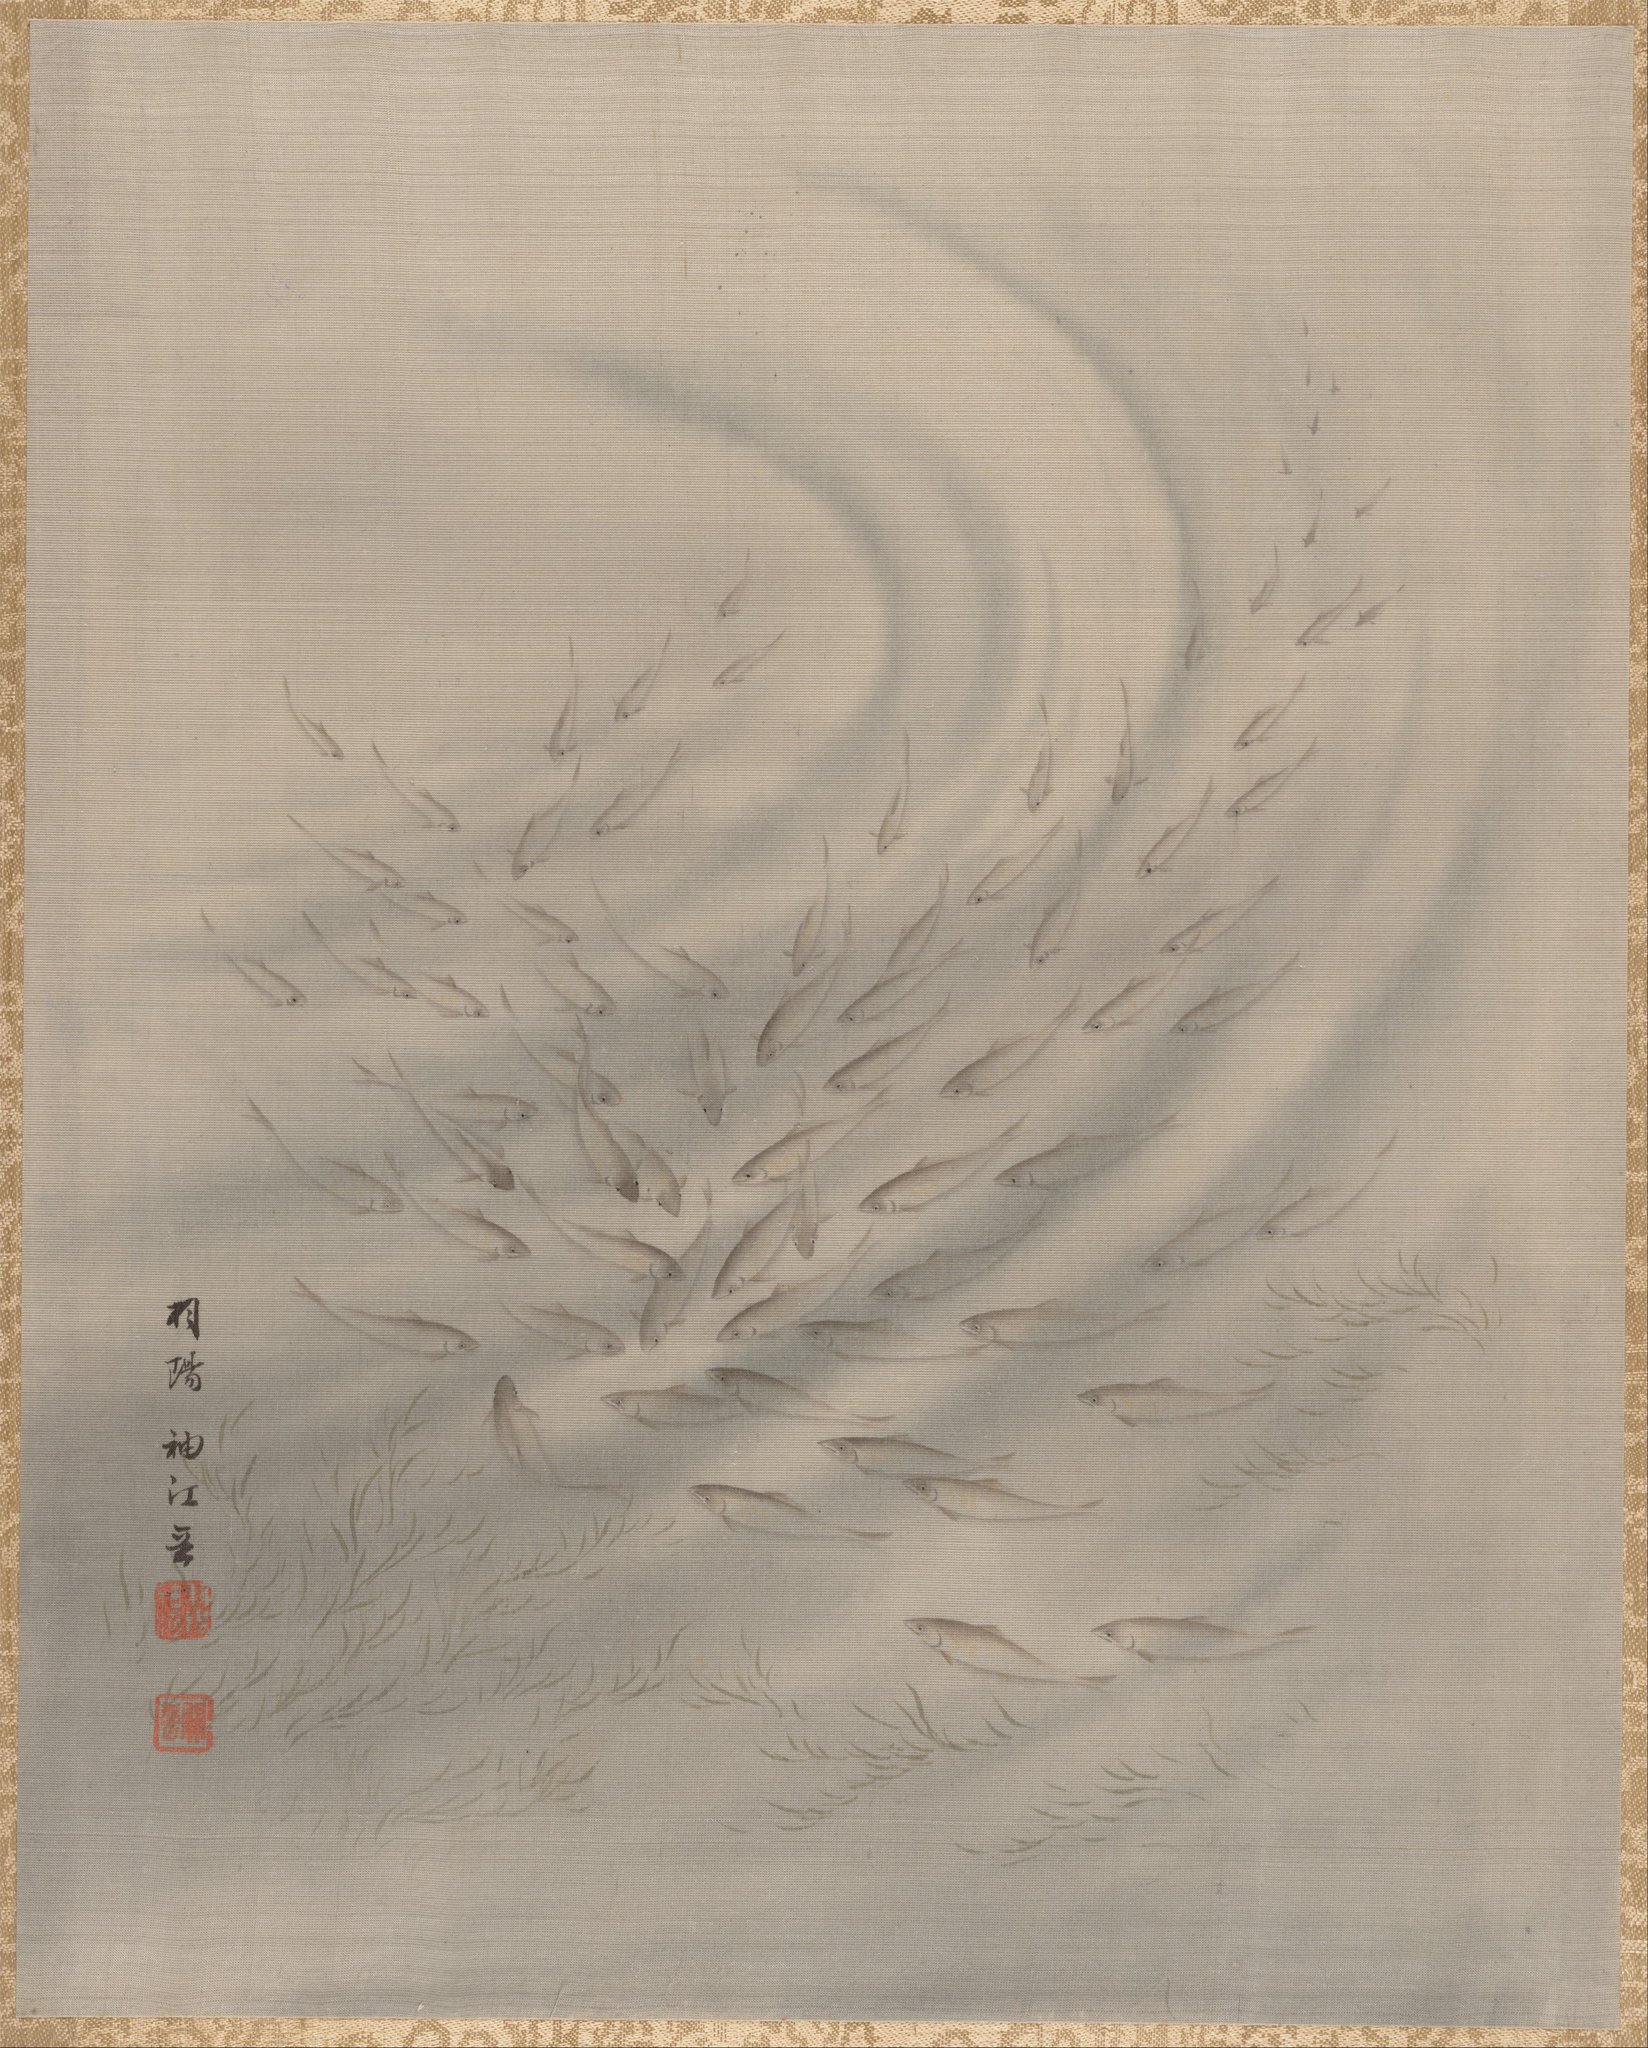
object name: album leaf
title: Small Fishes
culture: japanese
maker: seki shūkō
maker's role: artist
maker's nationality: japanese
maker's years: 1858-1915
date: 1890-1892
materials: silk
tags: fish